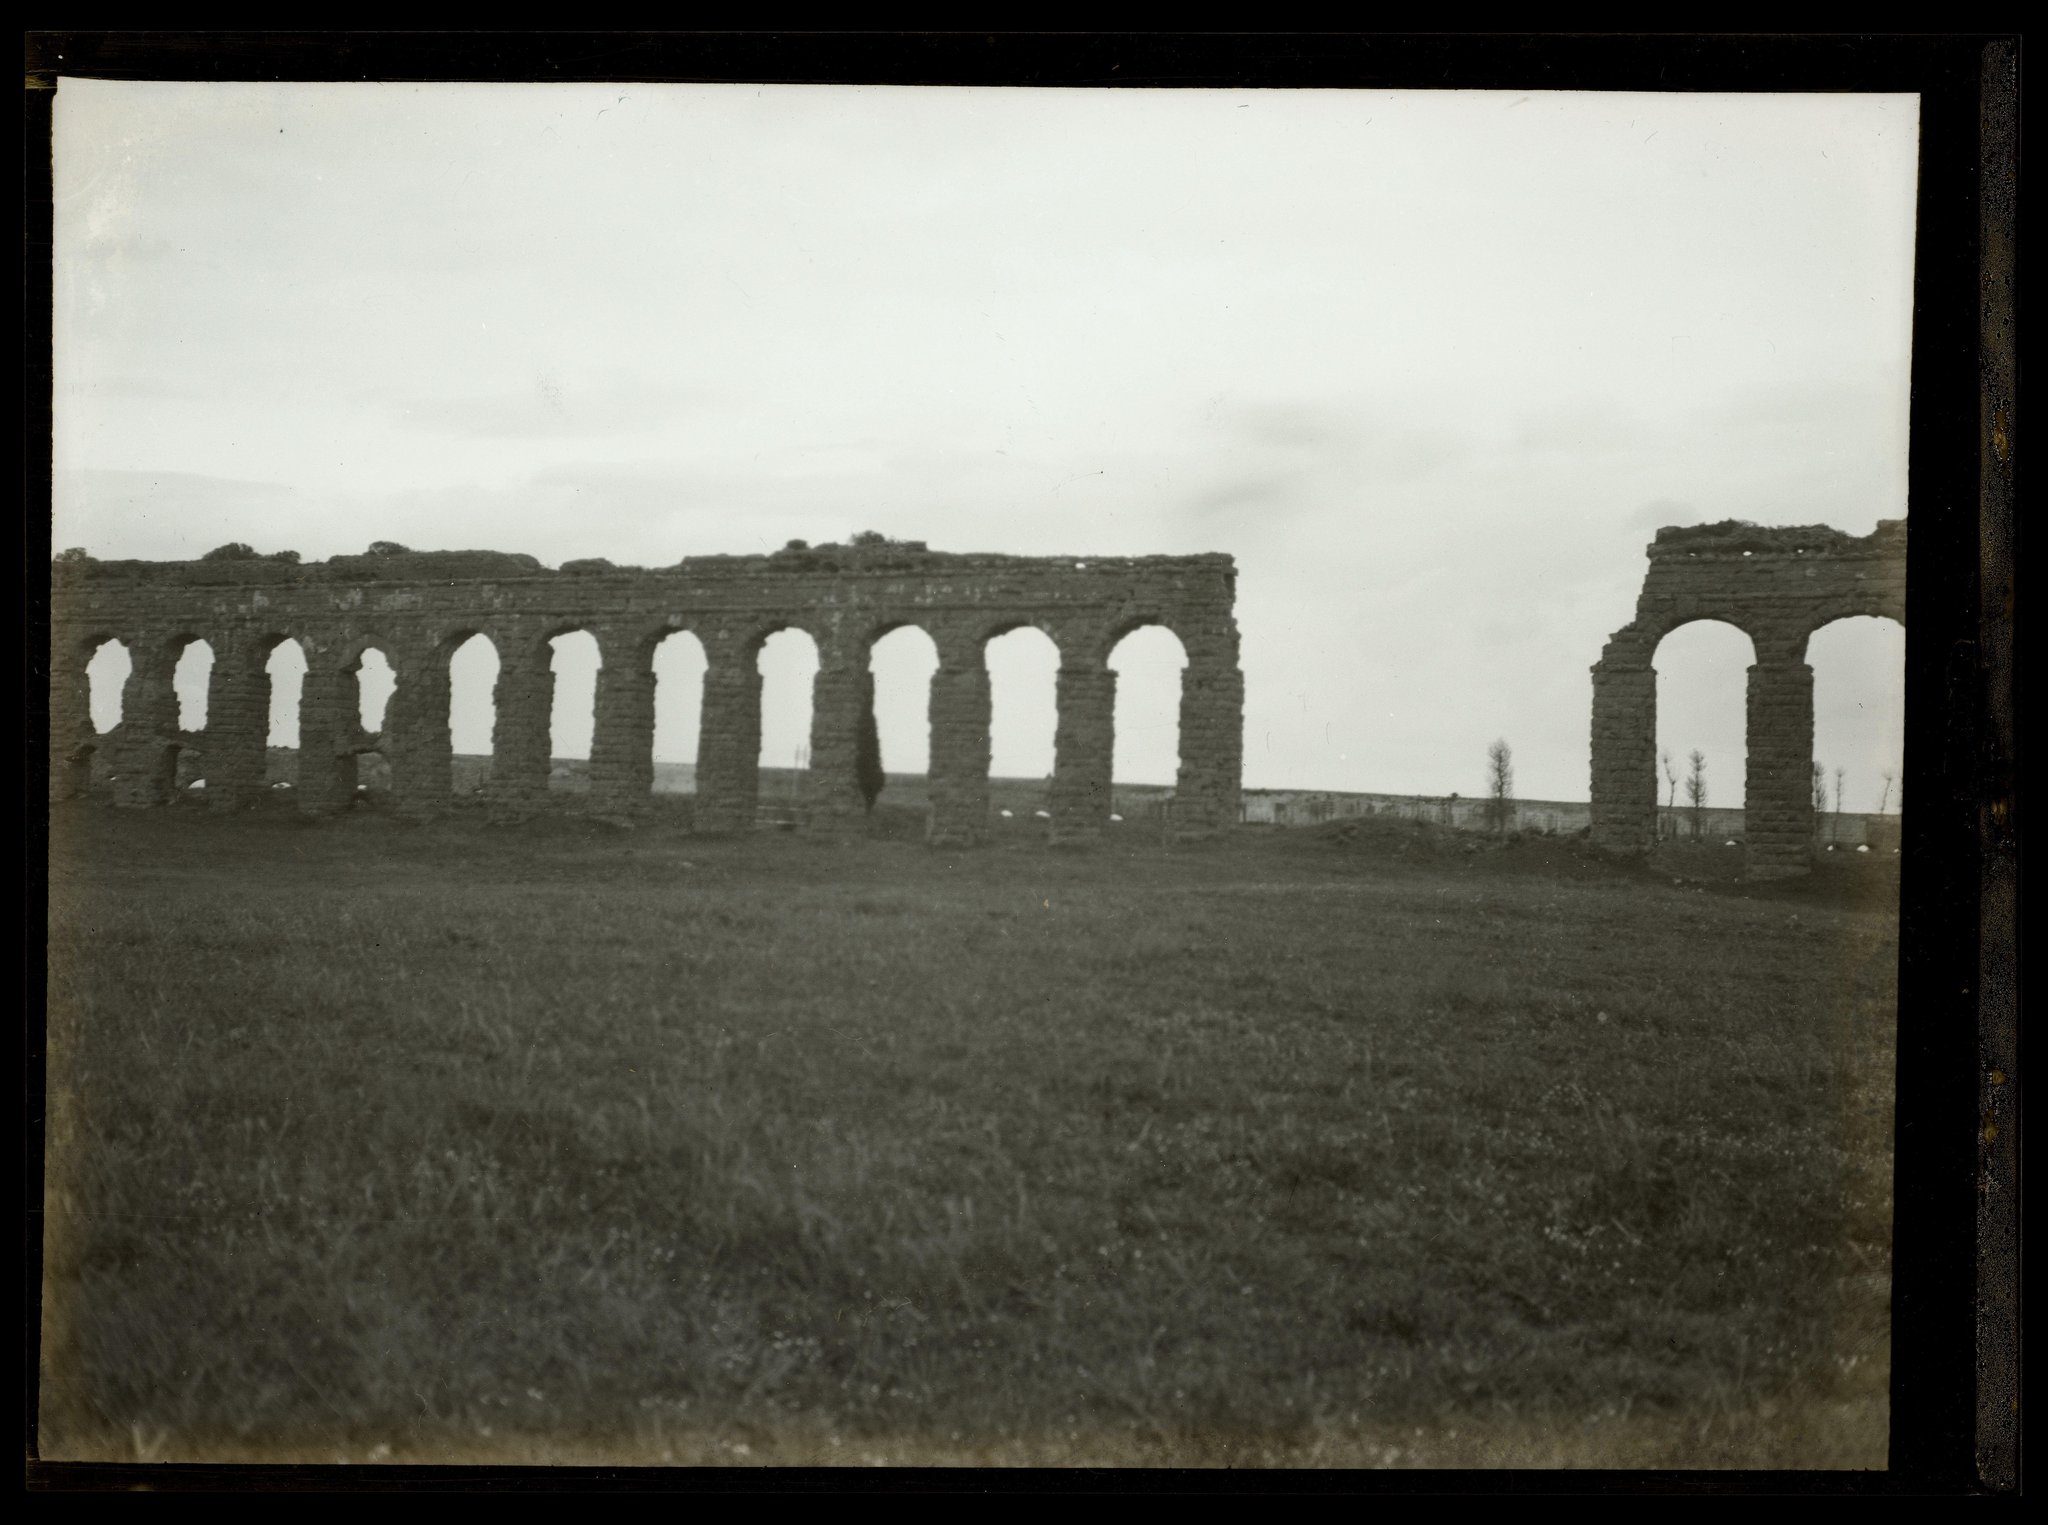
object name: negative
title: Filmnegatief met opname van Rome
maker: Anonymous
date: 1907-1935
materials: film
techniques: gelatin silver negative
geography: rome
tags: rome